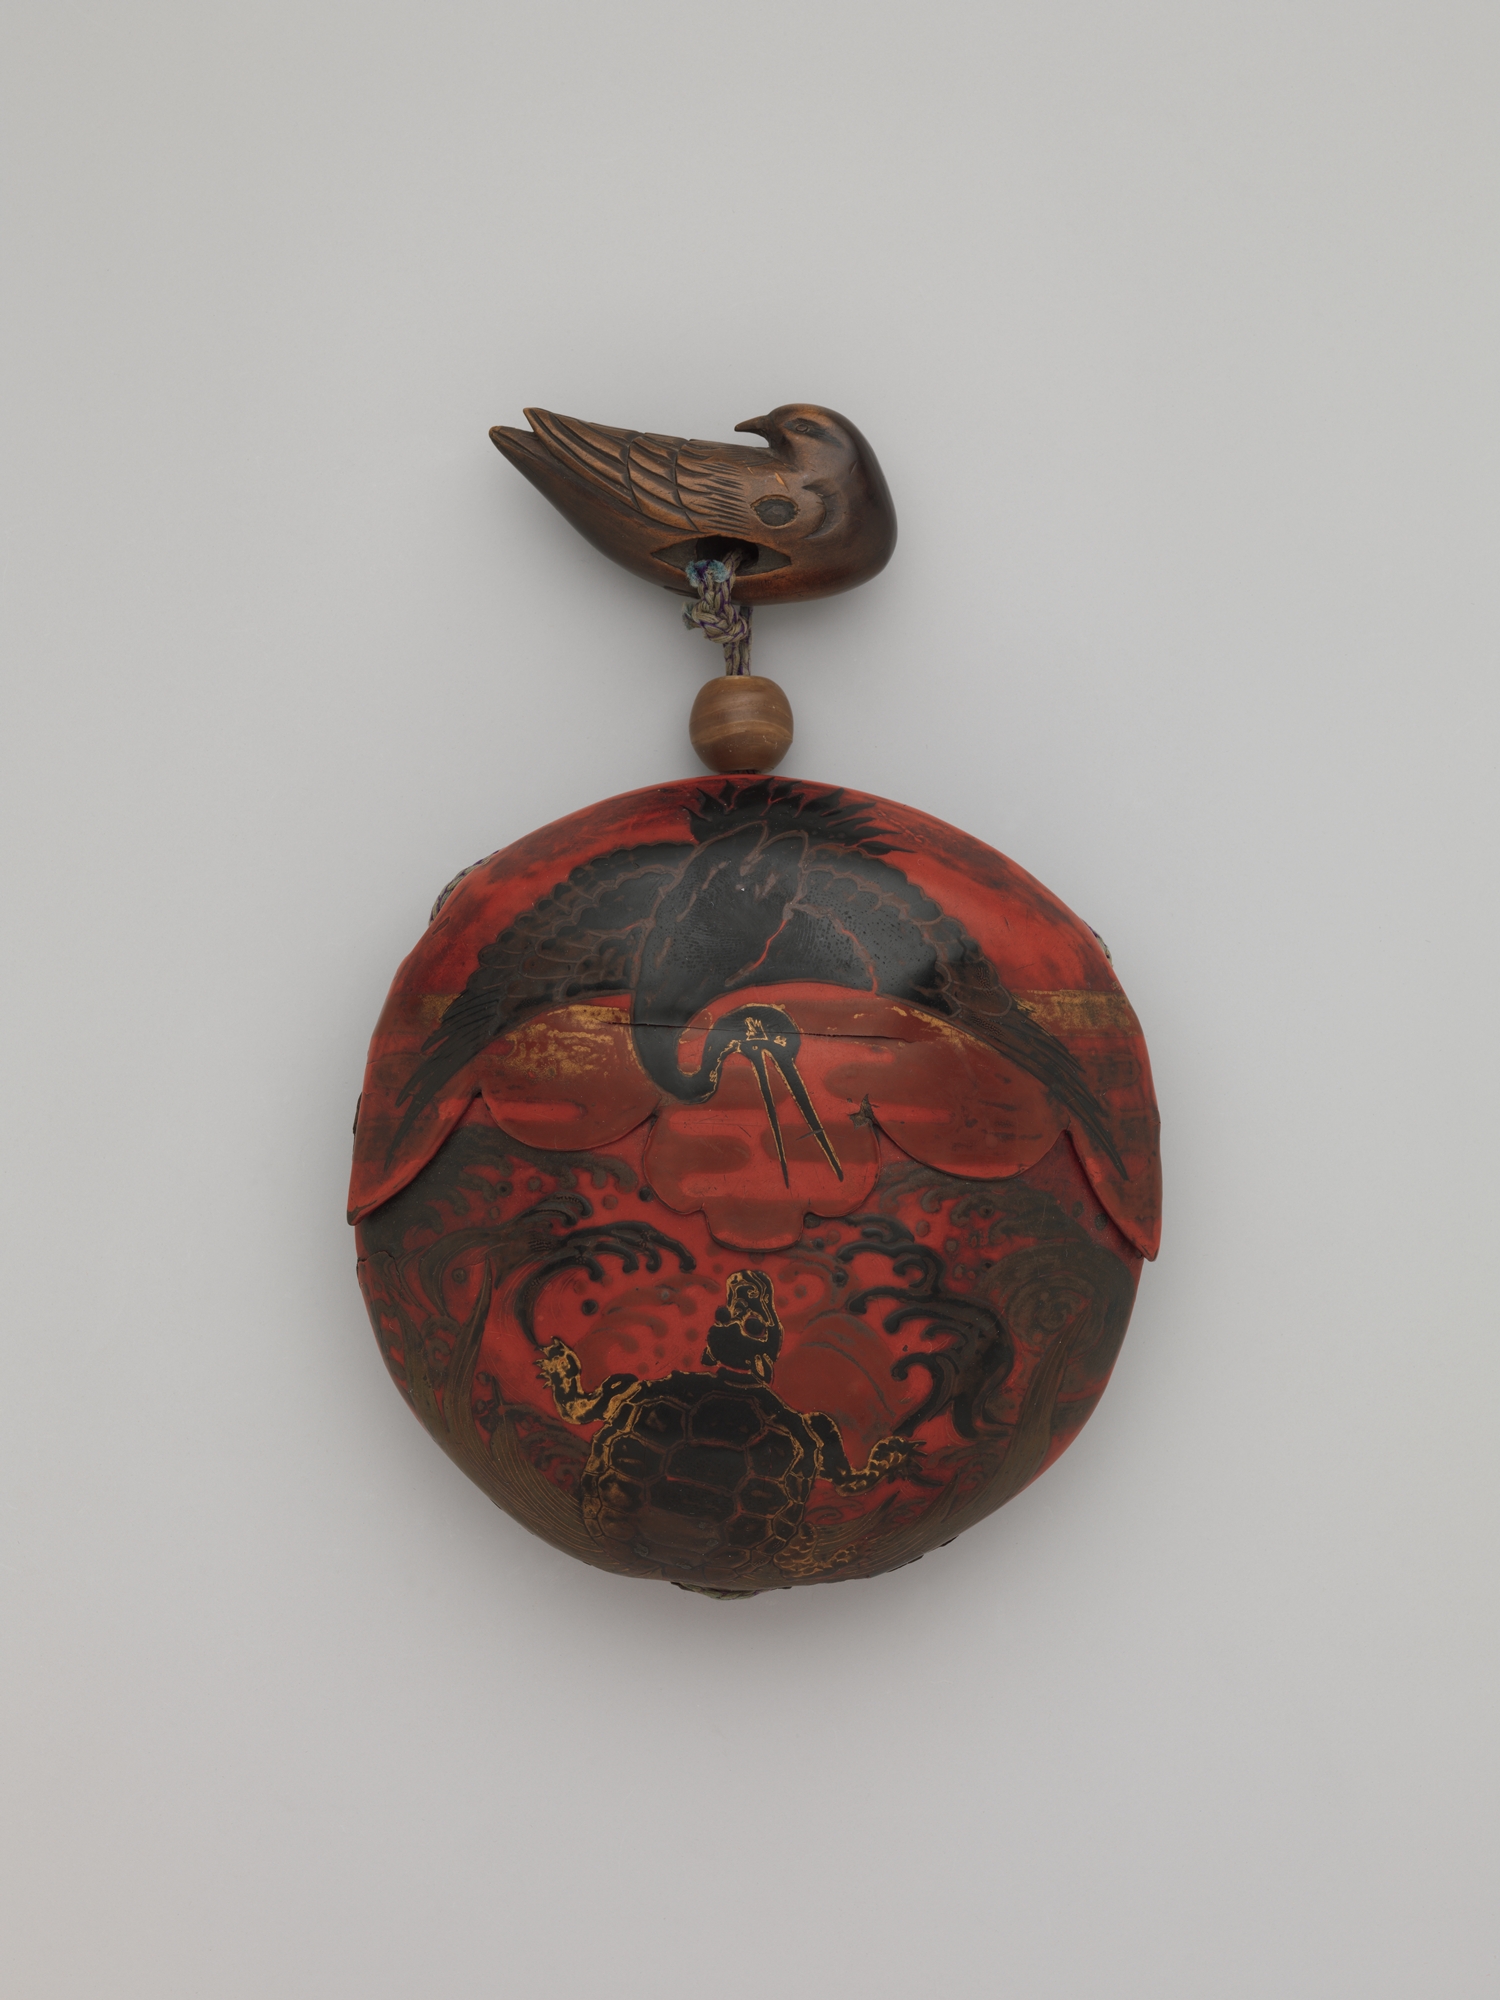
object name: tobacco pouch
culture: japanese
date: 1801-1900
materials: lacquer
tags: birds,turtles